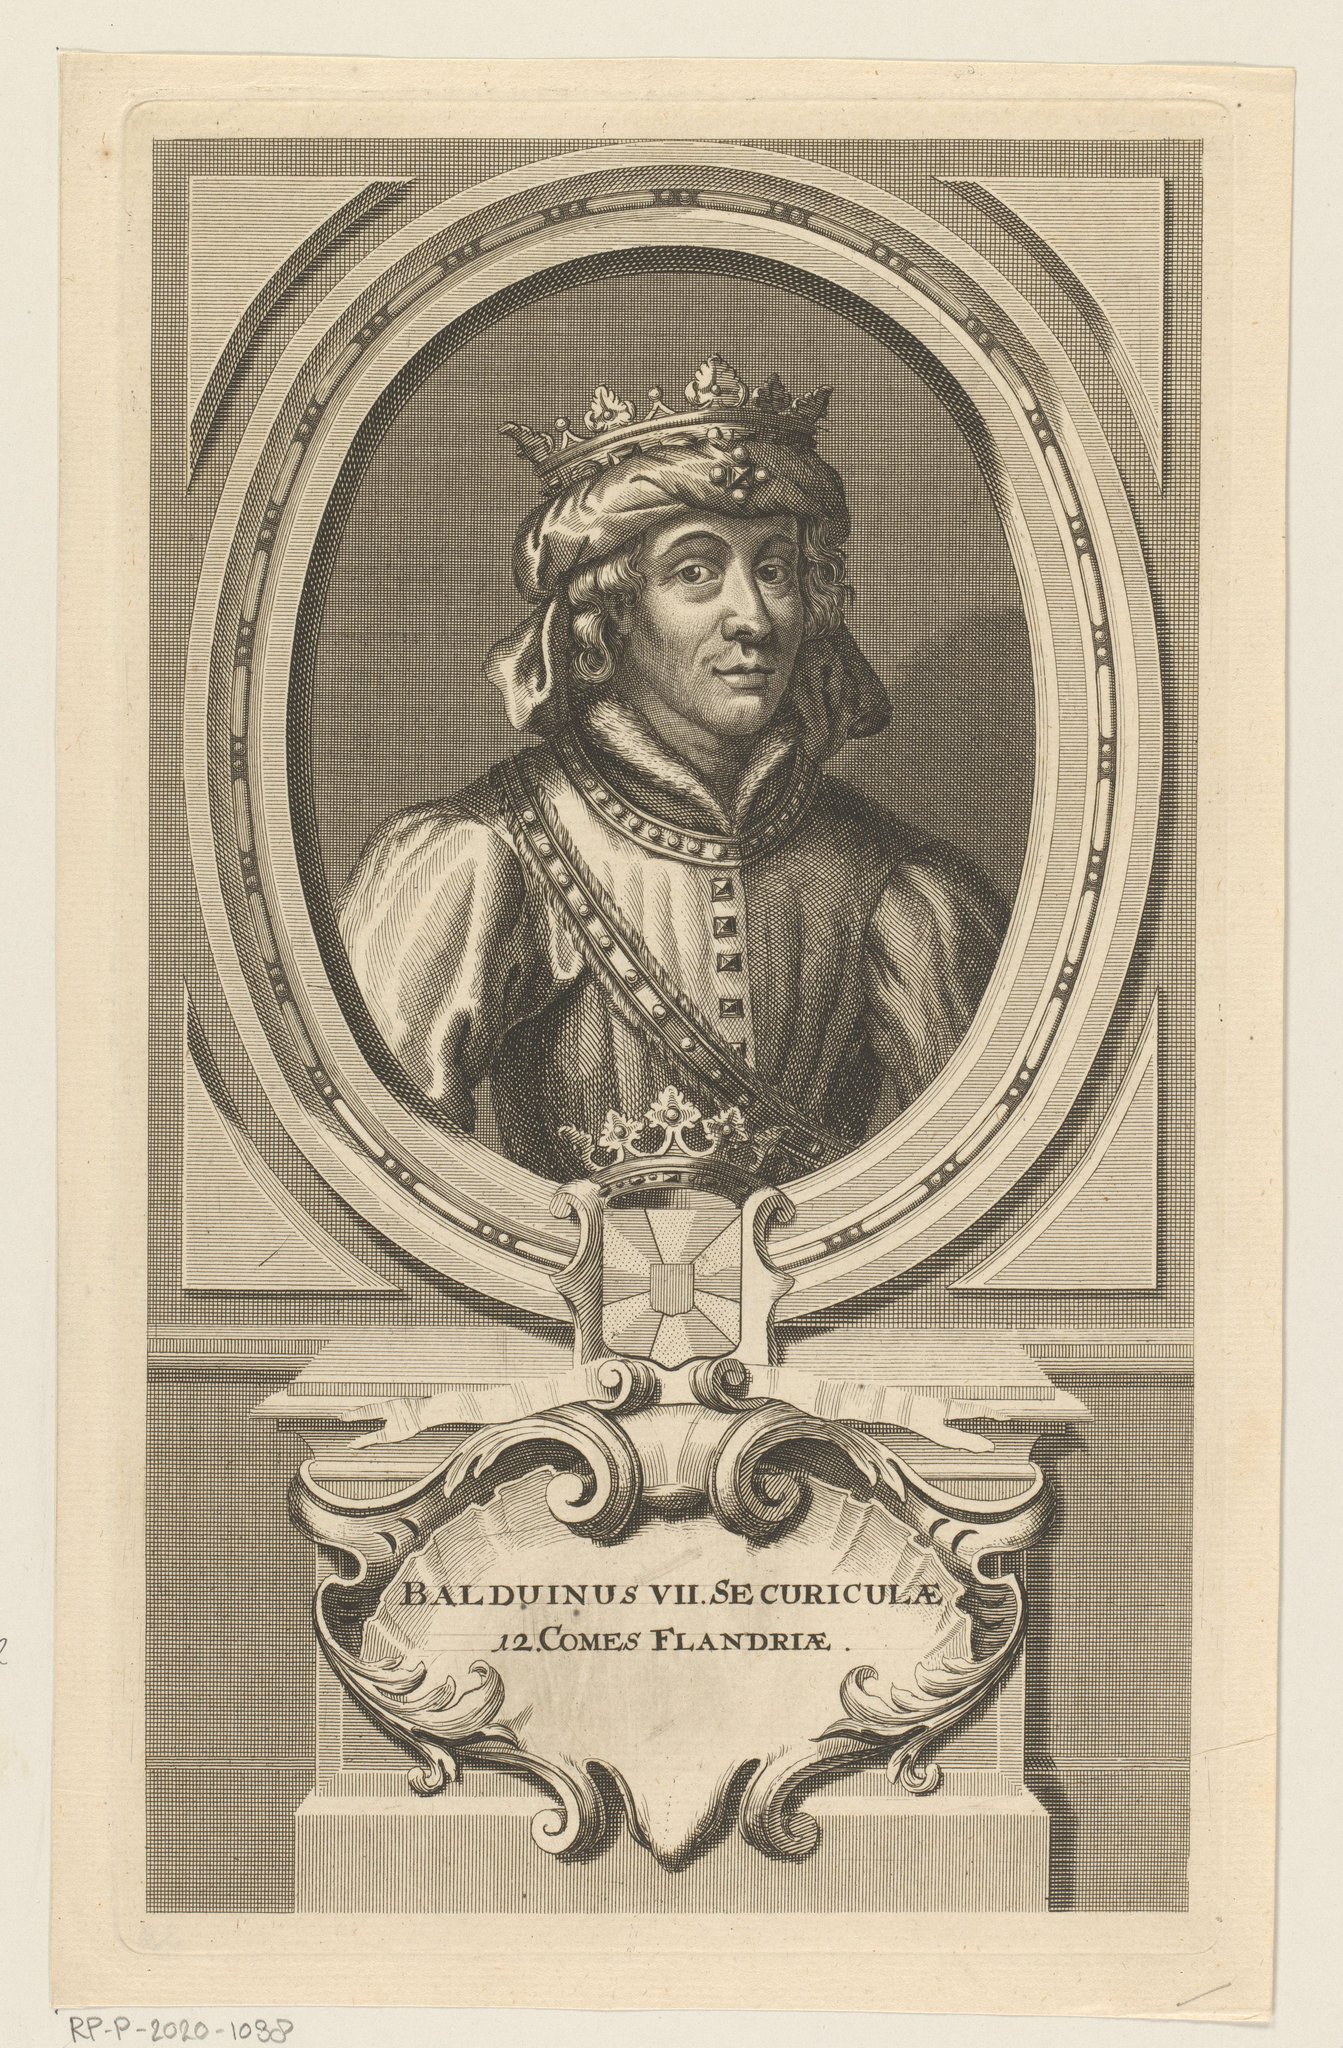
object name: print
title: Portret van keizer Constantius II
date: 1697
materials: paper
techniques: engraving, etching, letterpress printing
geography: utrecht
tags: historical persons, emperor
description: Prent uit: Bogaert, Abraham. De Roomsche monarchy, vertoont in de muntbeelden der westersche en oostersche keizeren (...). Utrecht: François Halma en Willem van de Water, 1697, p. 245. Eerste staat verschenen in een grotere prent met twaalf portretten, gedateerd 1695.